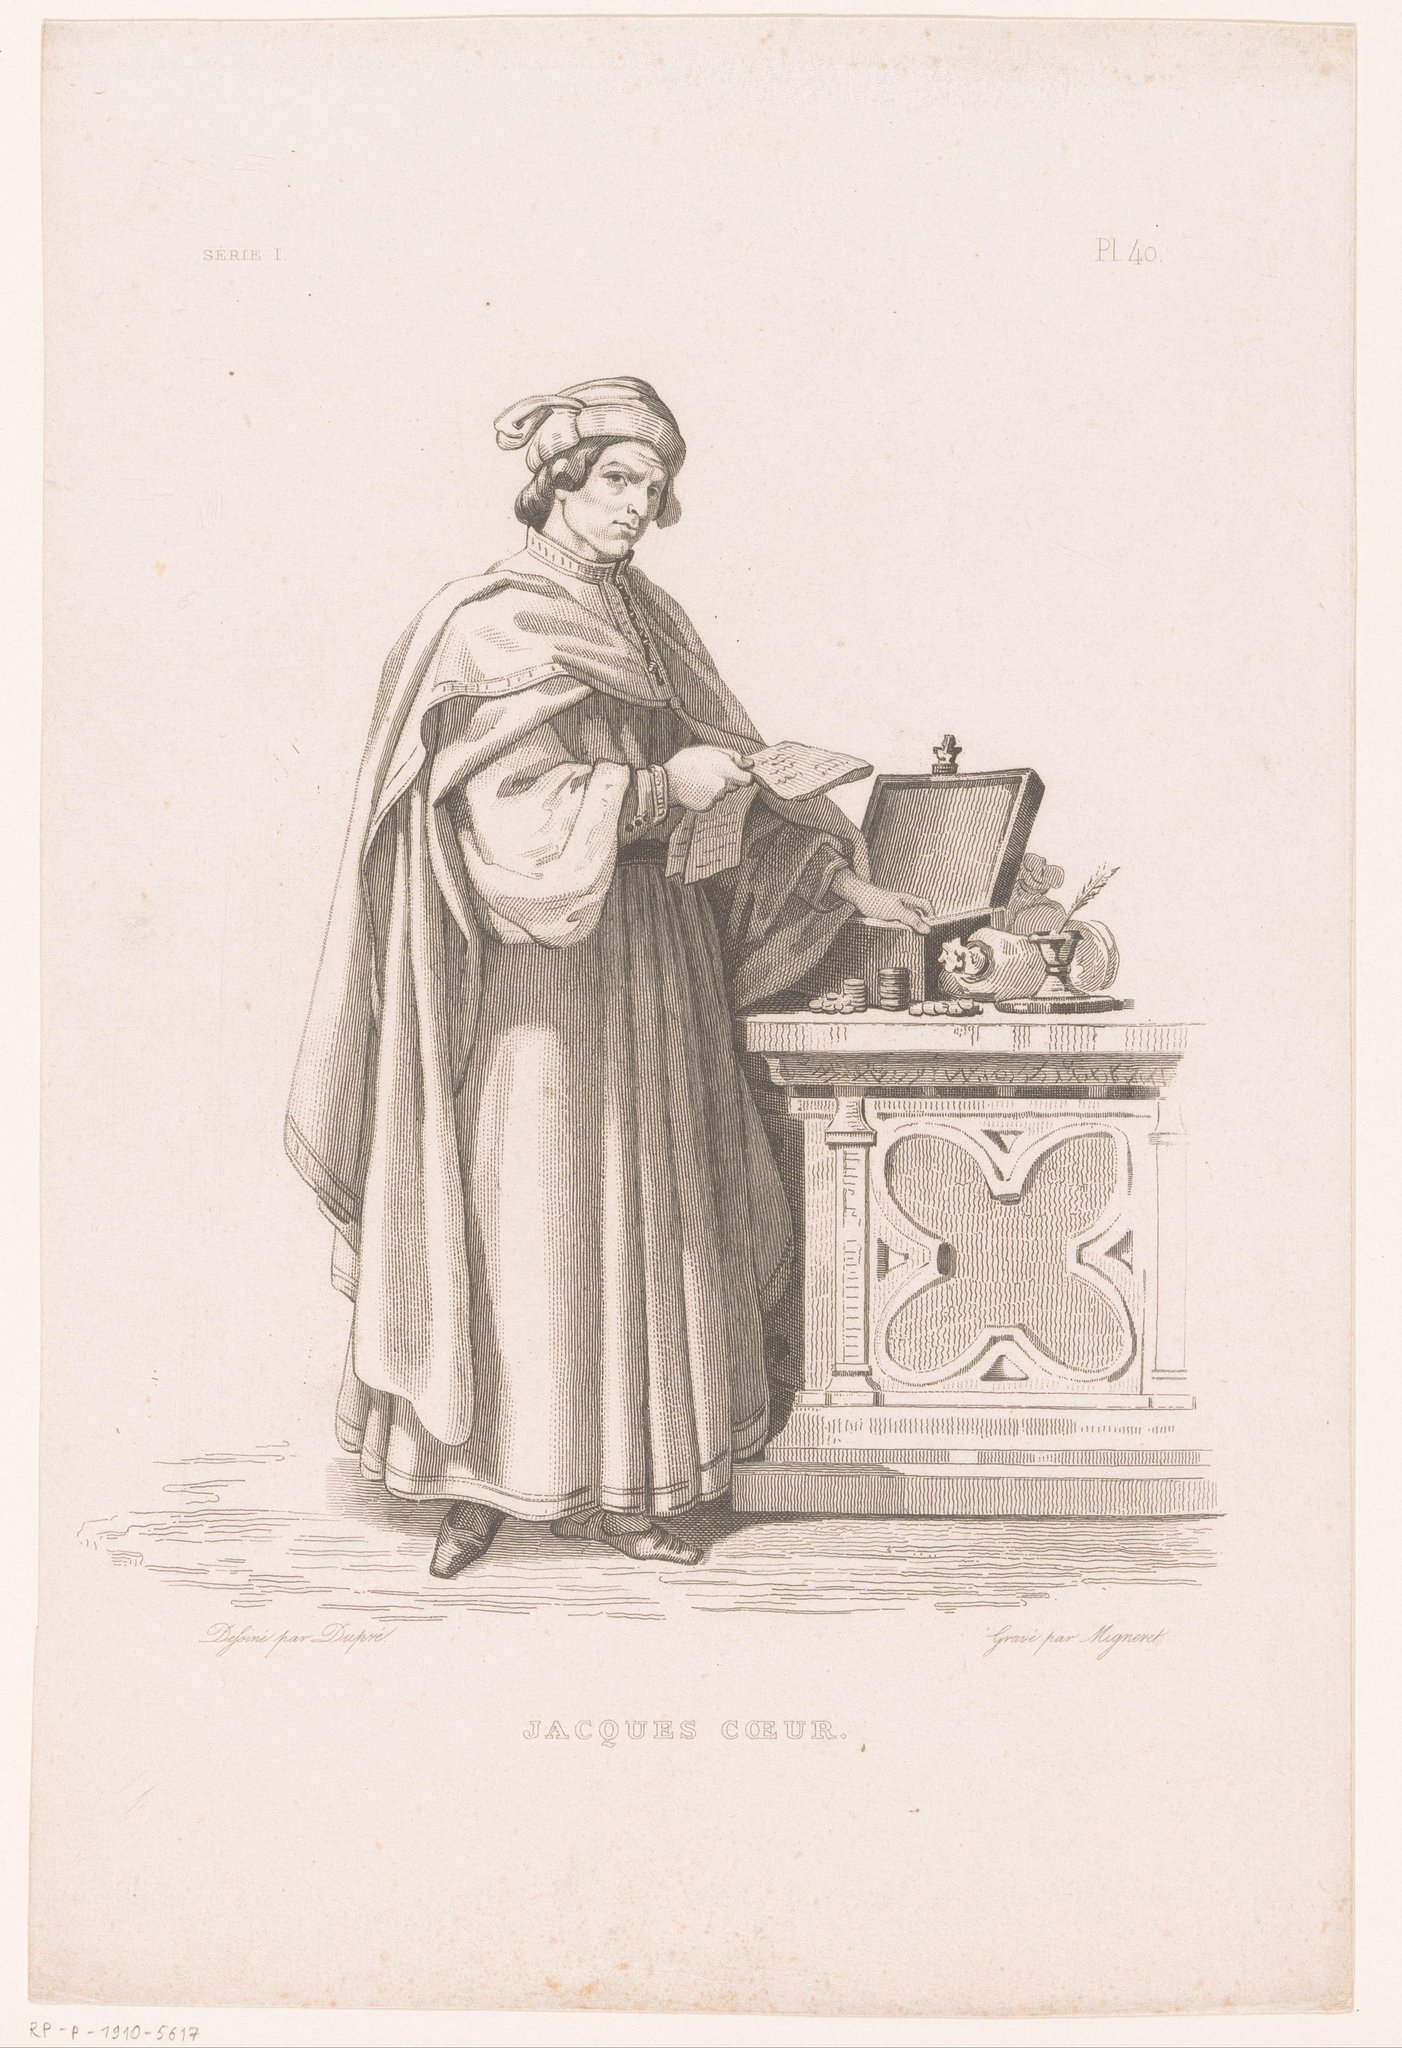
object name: print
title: Jacques Cœur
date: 1796-1840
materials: paper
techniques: etching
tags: historical persons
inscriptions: collector's mark: Lugt 2228